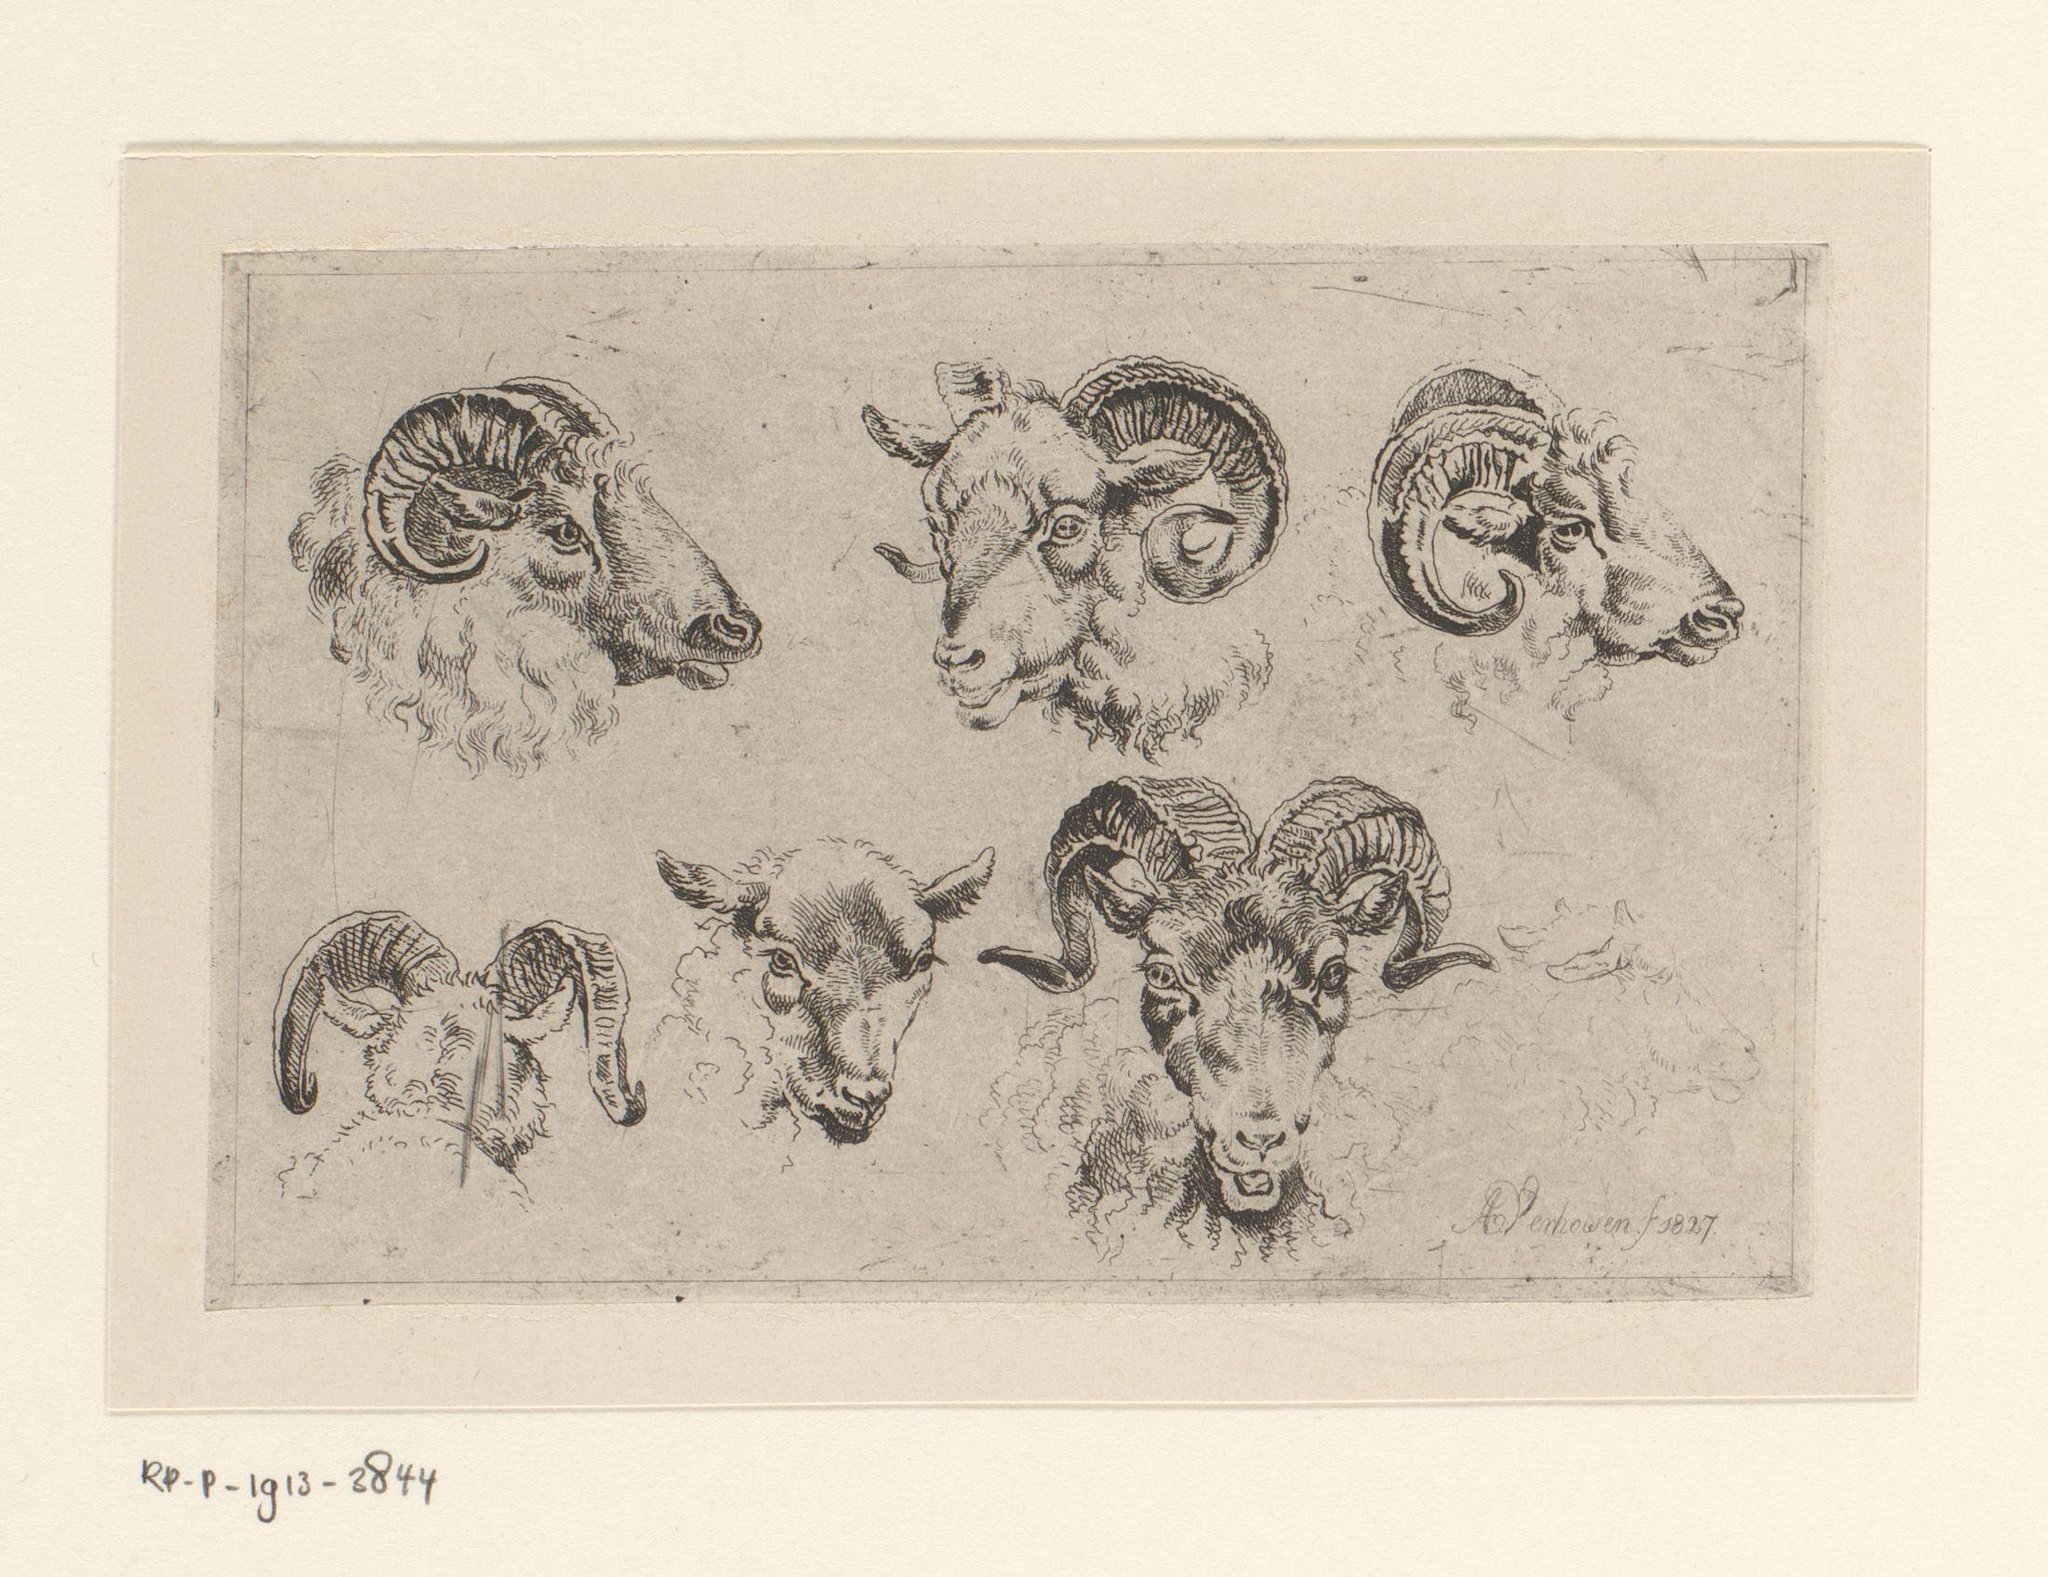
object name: print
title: Vijf ramskoppen en een schapenkop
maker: albertus verhoesen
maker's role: draughtsman, painter, print maker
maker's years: 1806-1881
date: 1827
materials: paper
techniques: etching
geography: netherlands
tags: ram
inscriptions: collector's mark: Lugt 2228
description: Vijf ramskoppen en een schapenkop, weergegeven in verschillende posities.